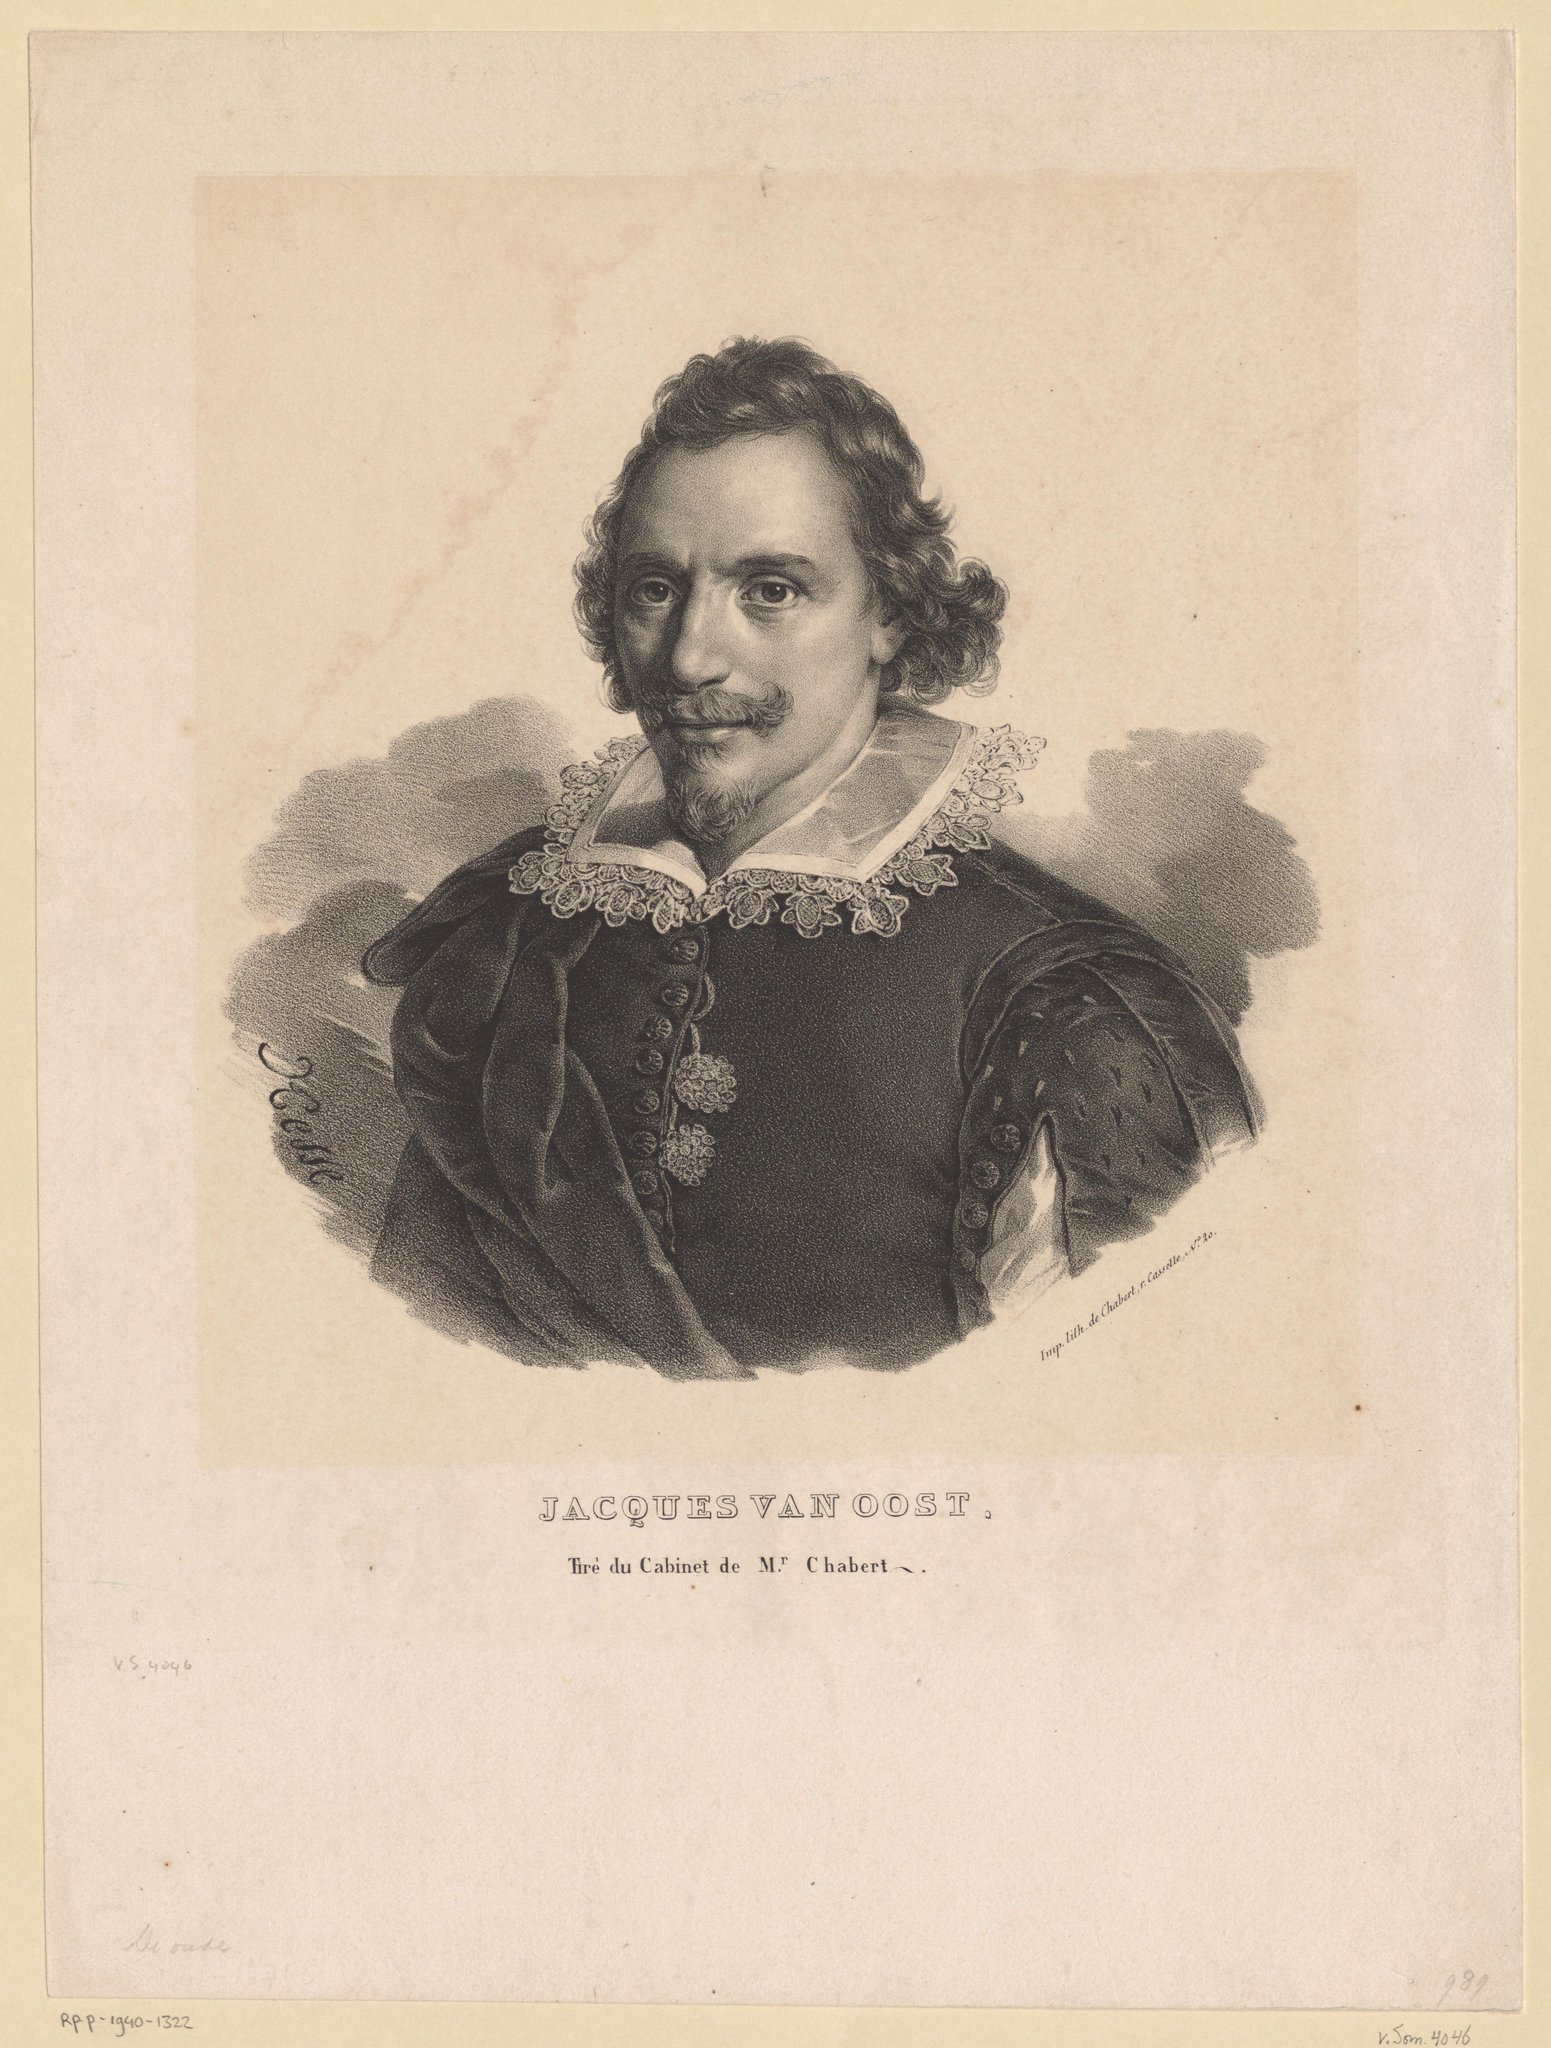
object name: print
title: Portret van Jacob van Oost I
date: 1822-1854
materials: paper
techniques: tone lithography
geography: paris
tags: bruges, painter, print maker, jacob van oost (i), adult man, historical persons, portrait, self-portrait of painter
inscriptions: collector's mark: Lugt 2228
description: Prent mogelijk uit: Chabert, Jean Claude. Galerie des peintres ou collection de portraits des peintres les plus célèbres de toutes les écoles. Accompagnée d'une notice sur chacun d'eux, et de copies de dessins originaux / Galerie des peintres ou collection de portraits des peintres les plus célèbres de toutes les écoles. Accompagnée de leur notice historique, de leurs dessins et d'un discours sur les arts. Parijs: Jean Claude Chabert, [1822-1834]. De samenstelling van tegenwoordig bekende en al dan niet gebonden exemplaren van deze uitgave verschilt. Dit omdat de prenten en bijhorende stukken tekst op inschrijving en waarschijnlijk ook los verkrijgbaar waren.